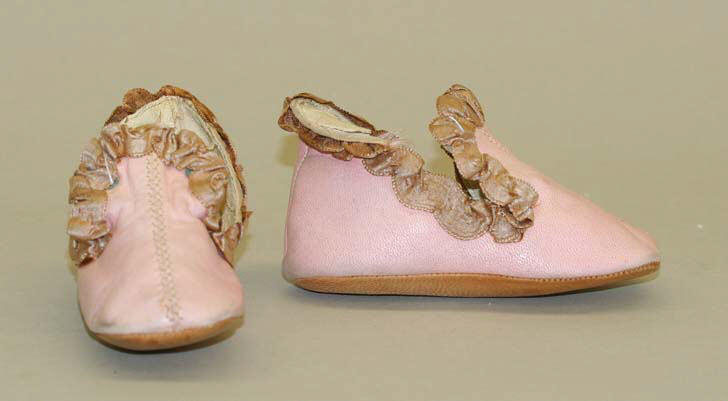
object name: shoe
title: Shoes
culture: american or european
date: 1878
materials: leather, silk